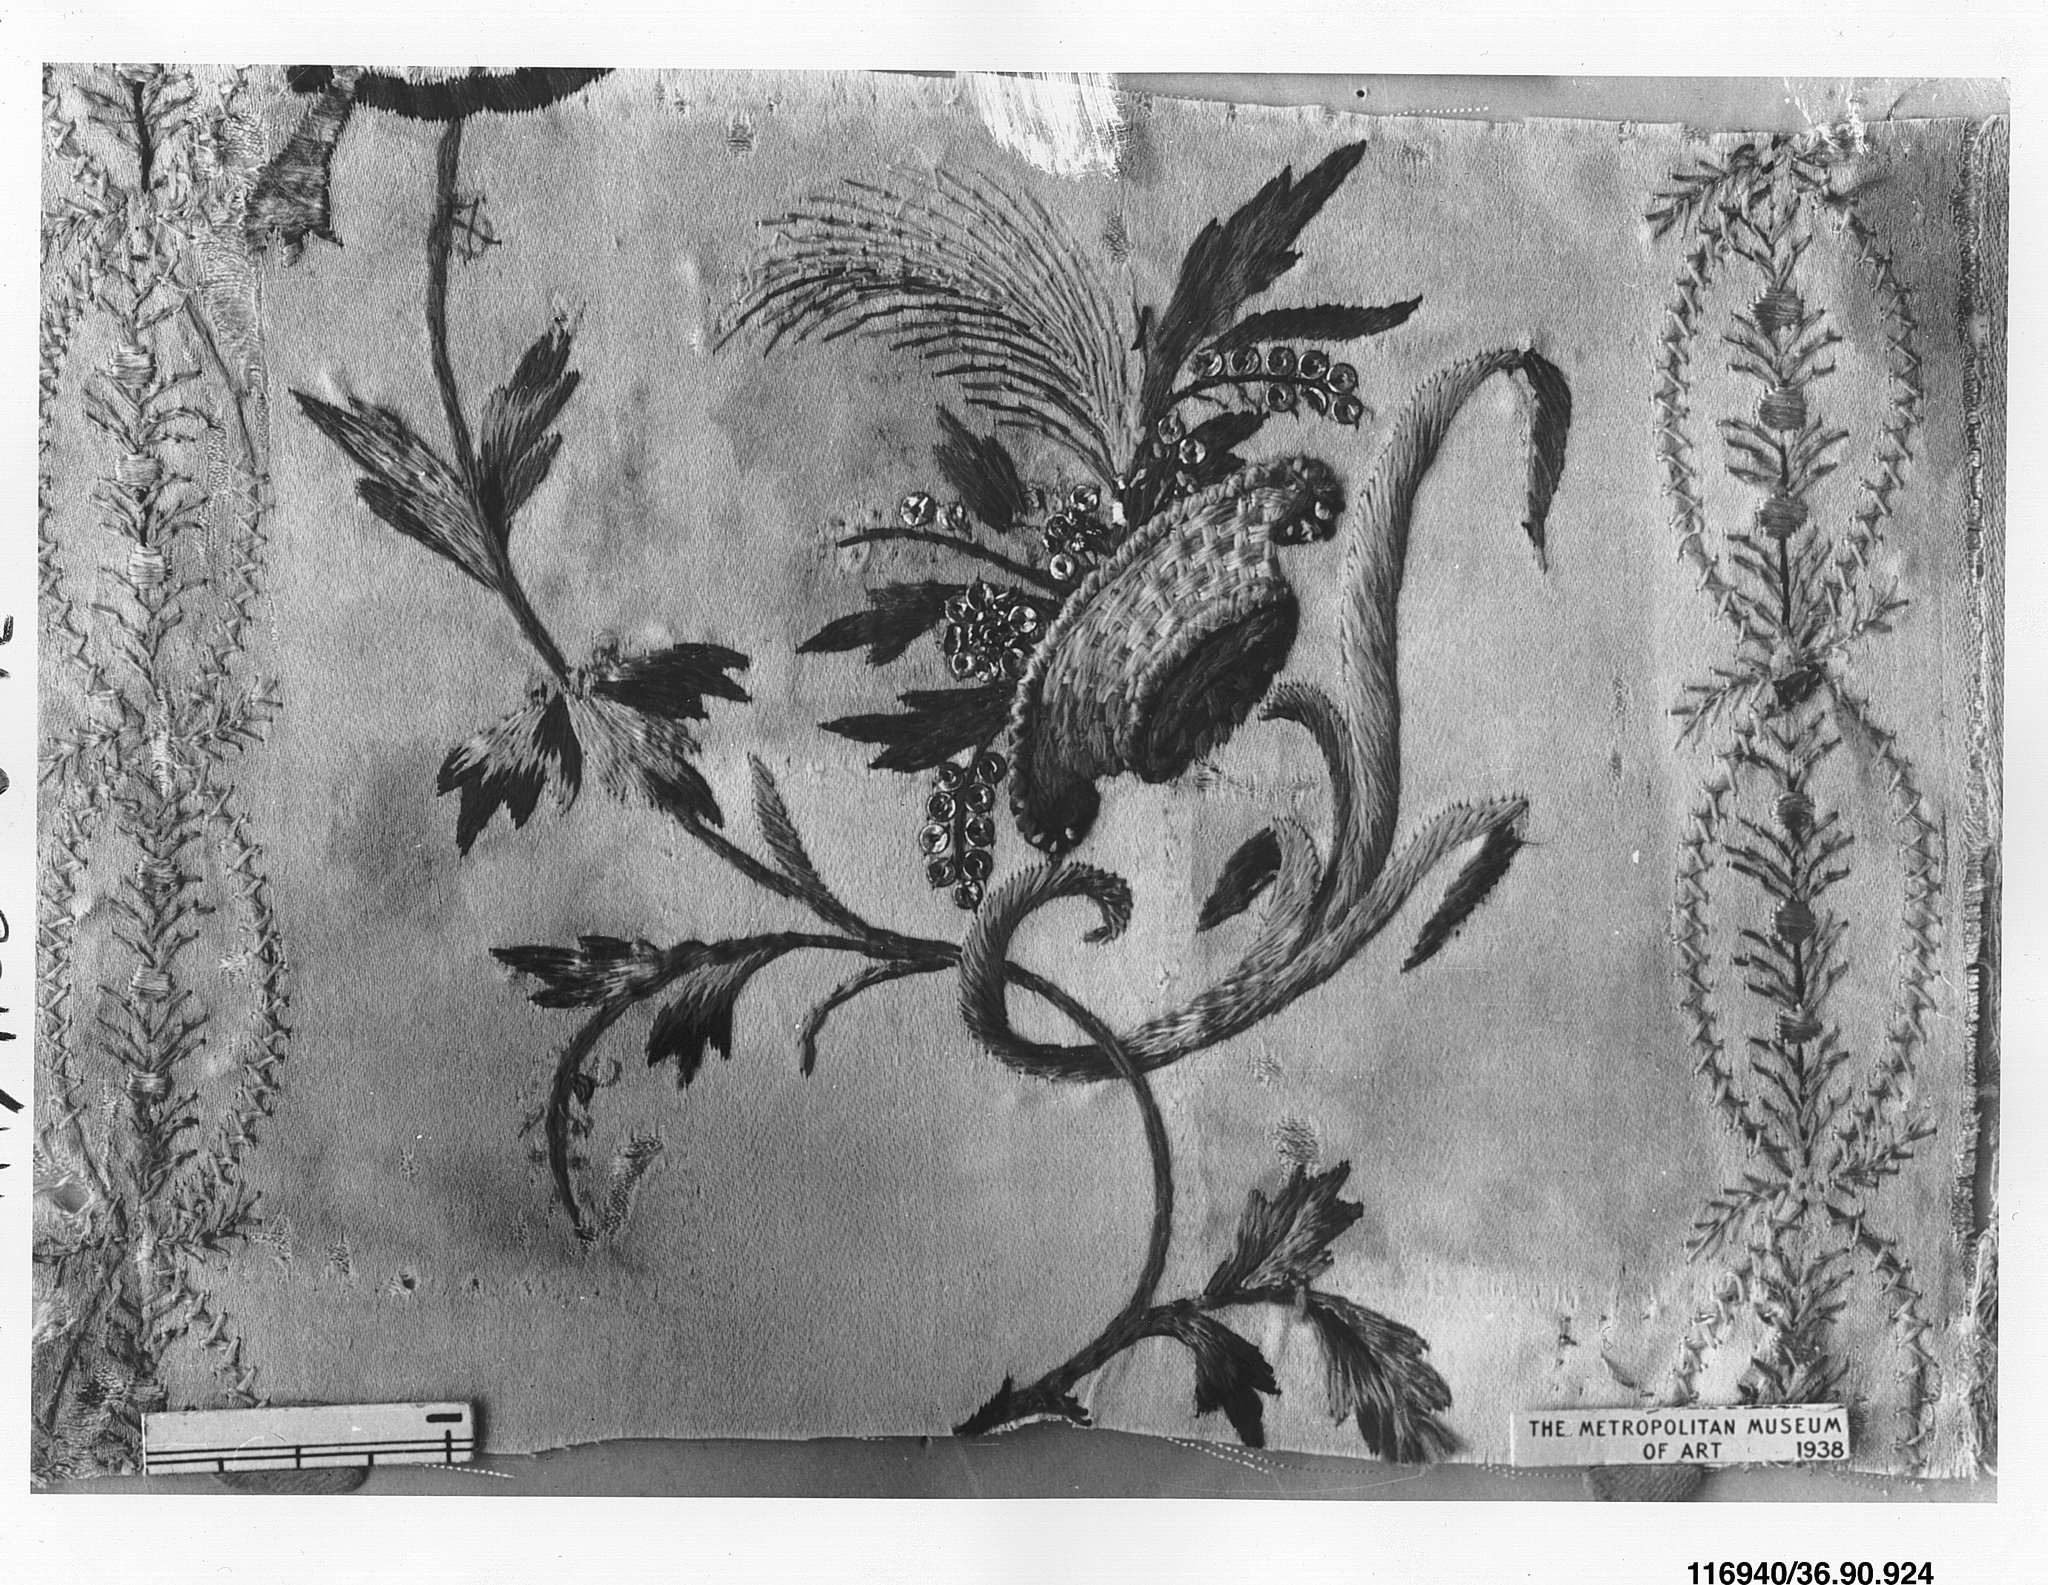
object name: piece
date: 1701-1800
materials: silk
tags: flowers,leaves